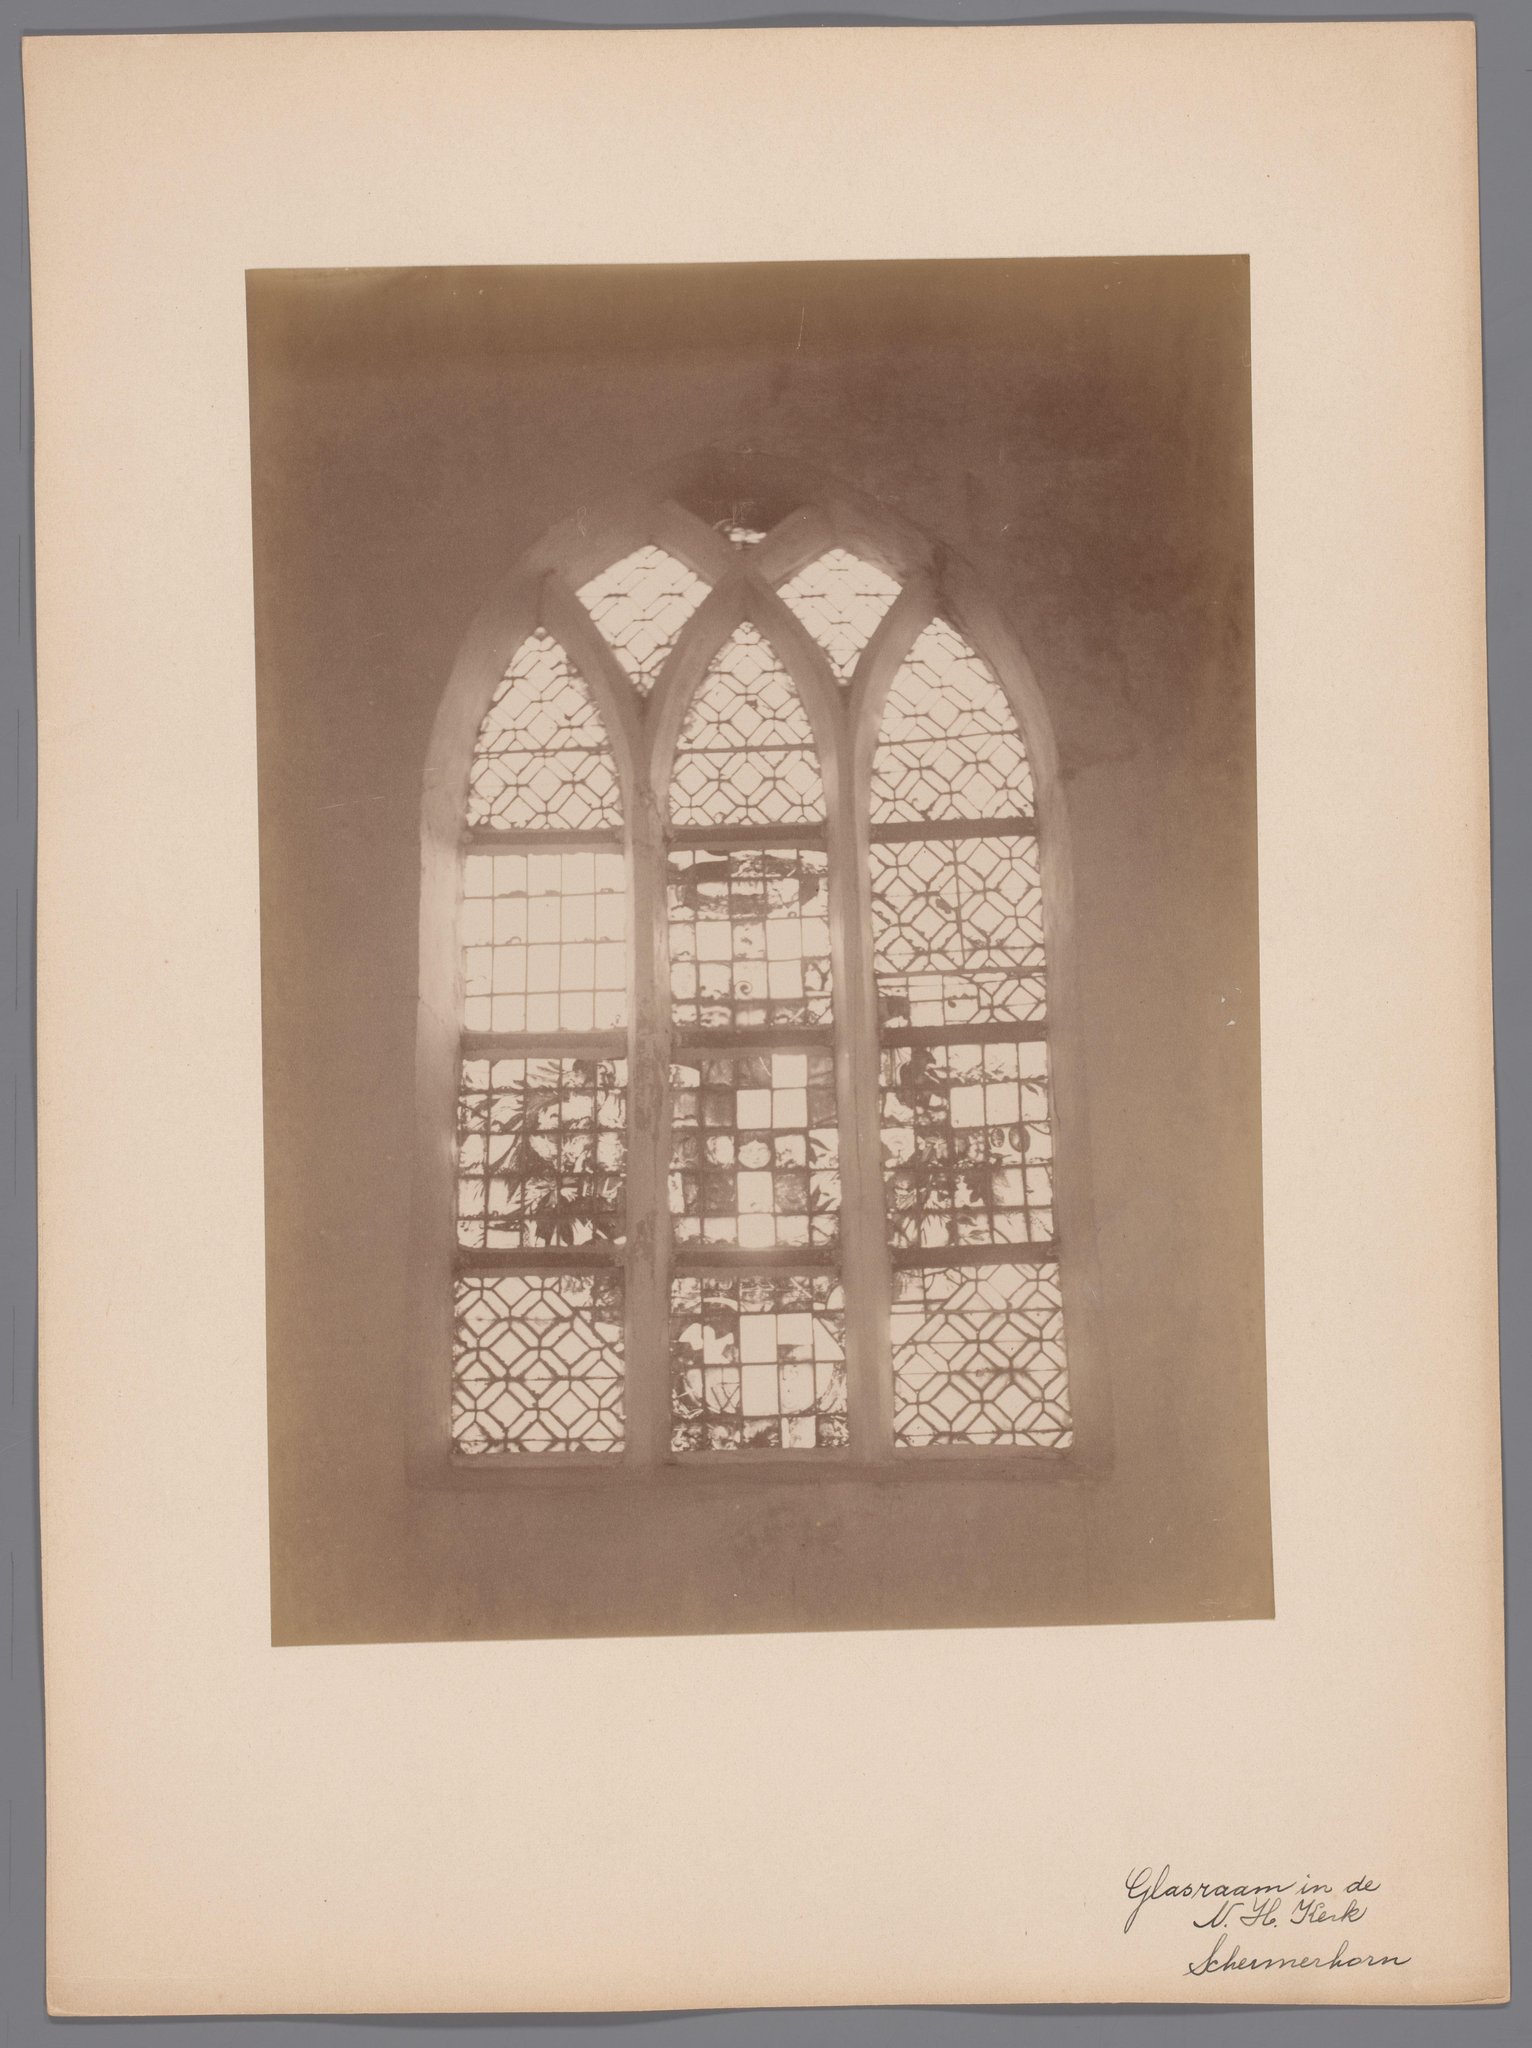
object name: photograph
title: Geschilderd raam in de Grote Kerk te Schermerhorn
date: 1890-1910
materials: cardboard, photographic support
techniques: albumen print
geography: schermerhorn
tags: church-window, e.g. rose-window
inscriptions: annotation: ‘Glasraam in de N.H. Kerk/ Schermerhorn’, annotation: ‘Schermerhorn/ Glasraam in de Ned. Herv. Kerk’